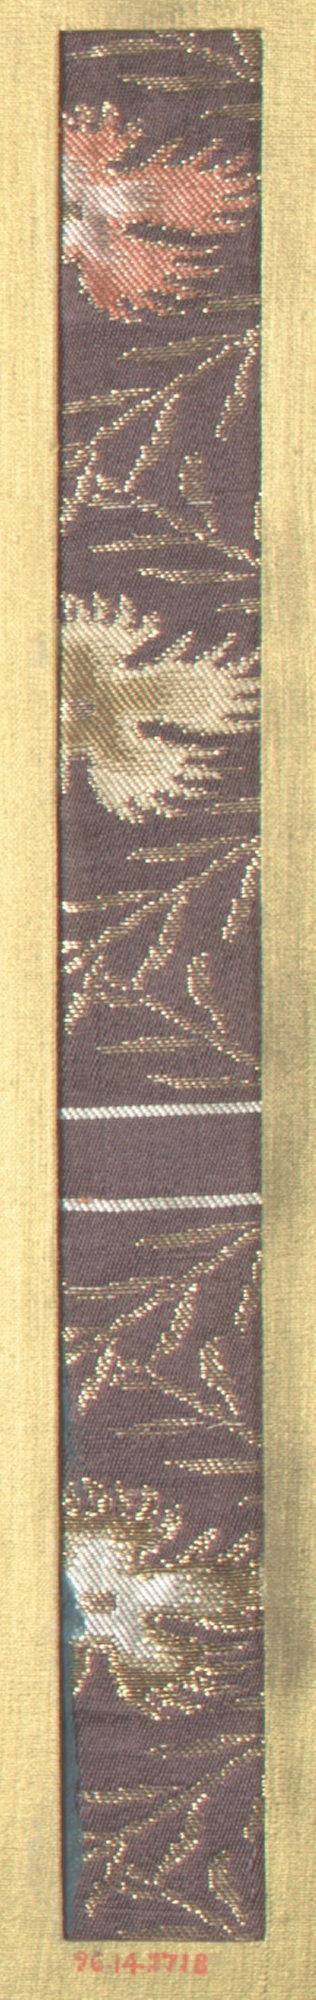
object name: piece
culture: japanese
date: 1701-1900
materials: silk